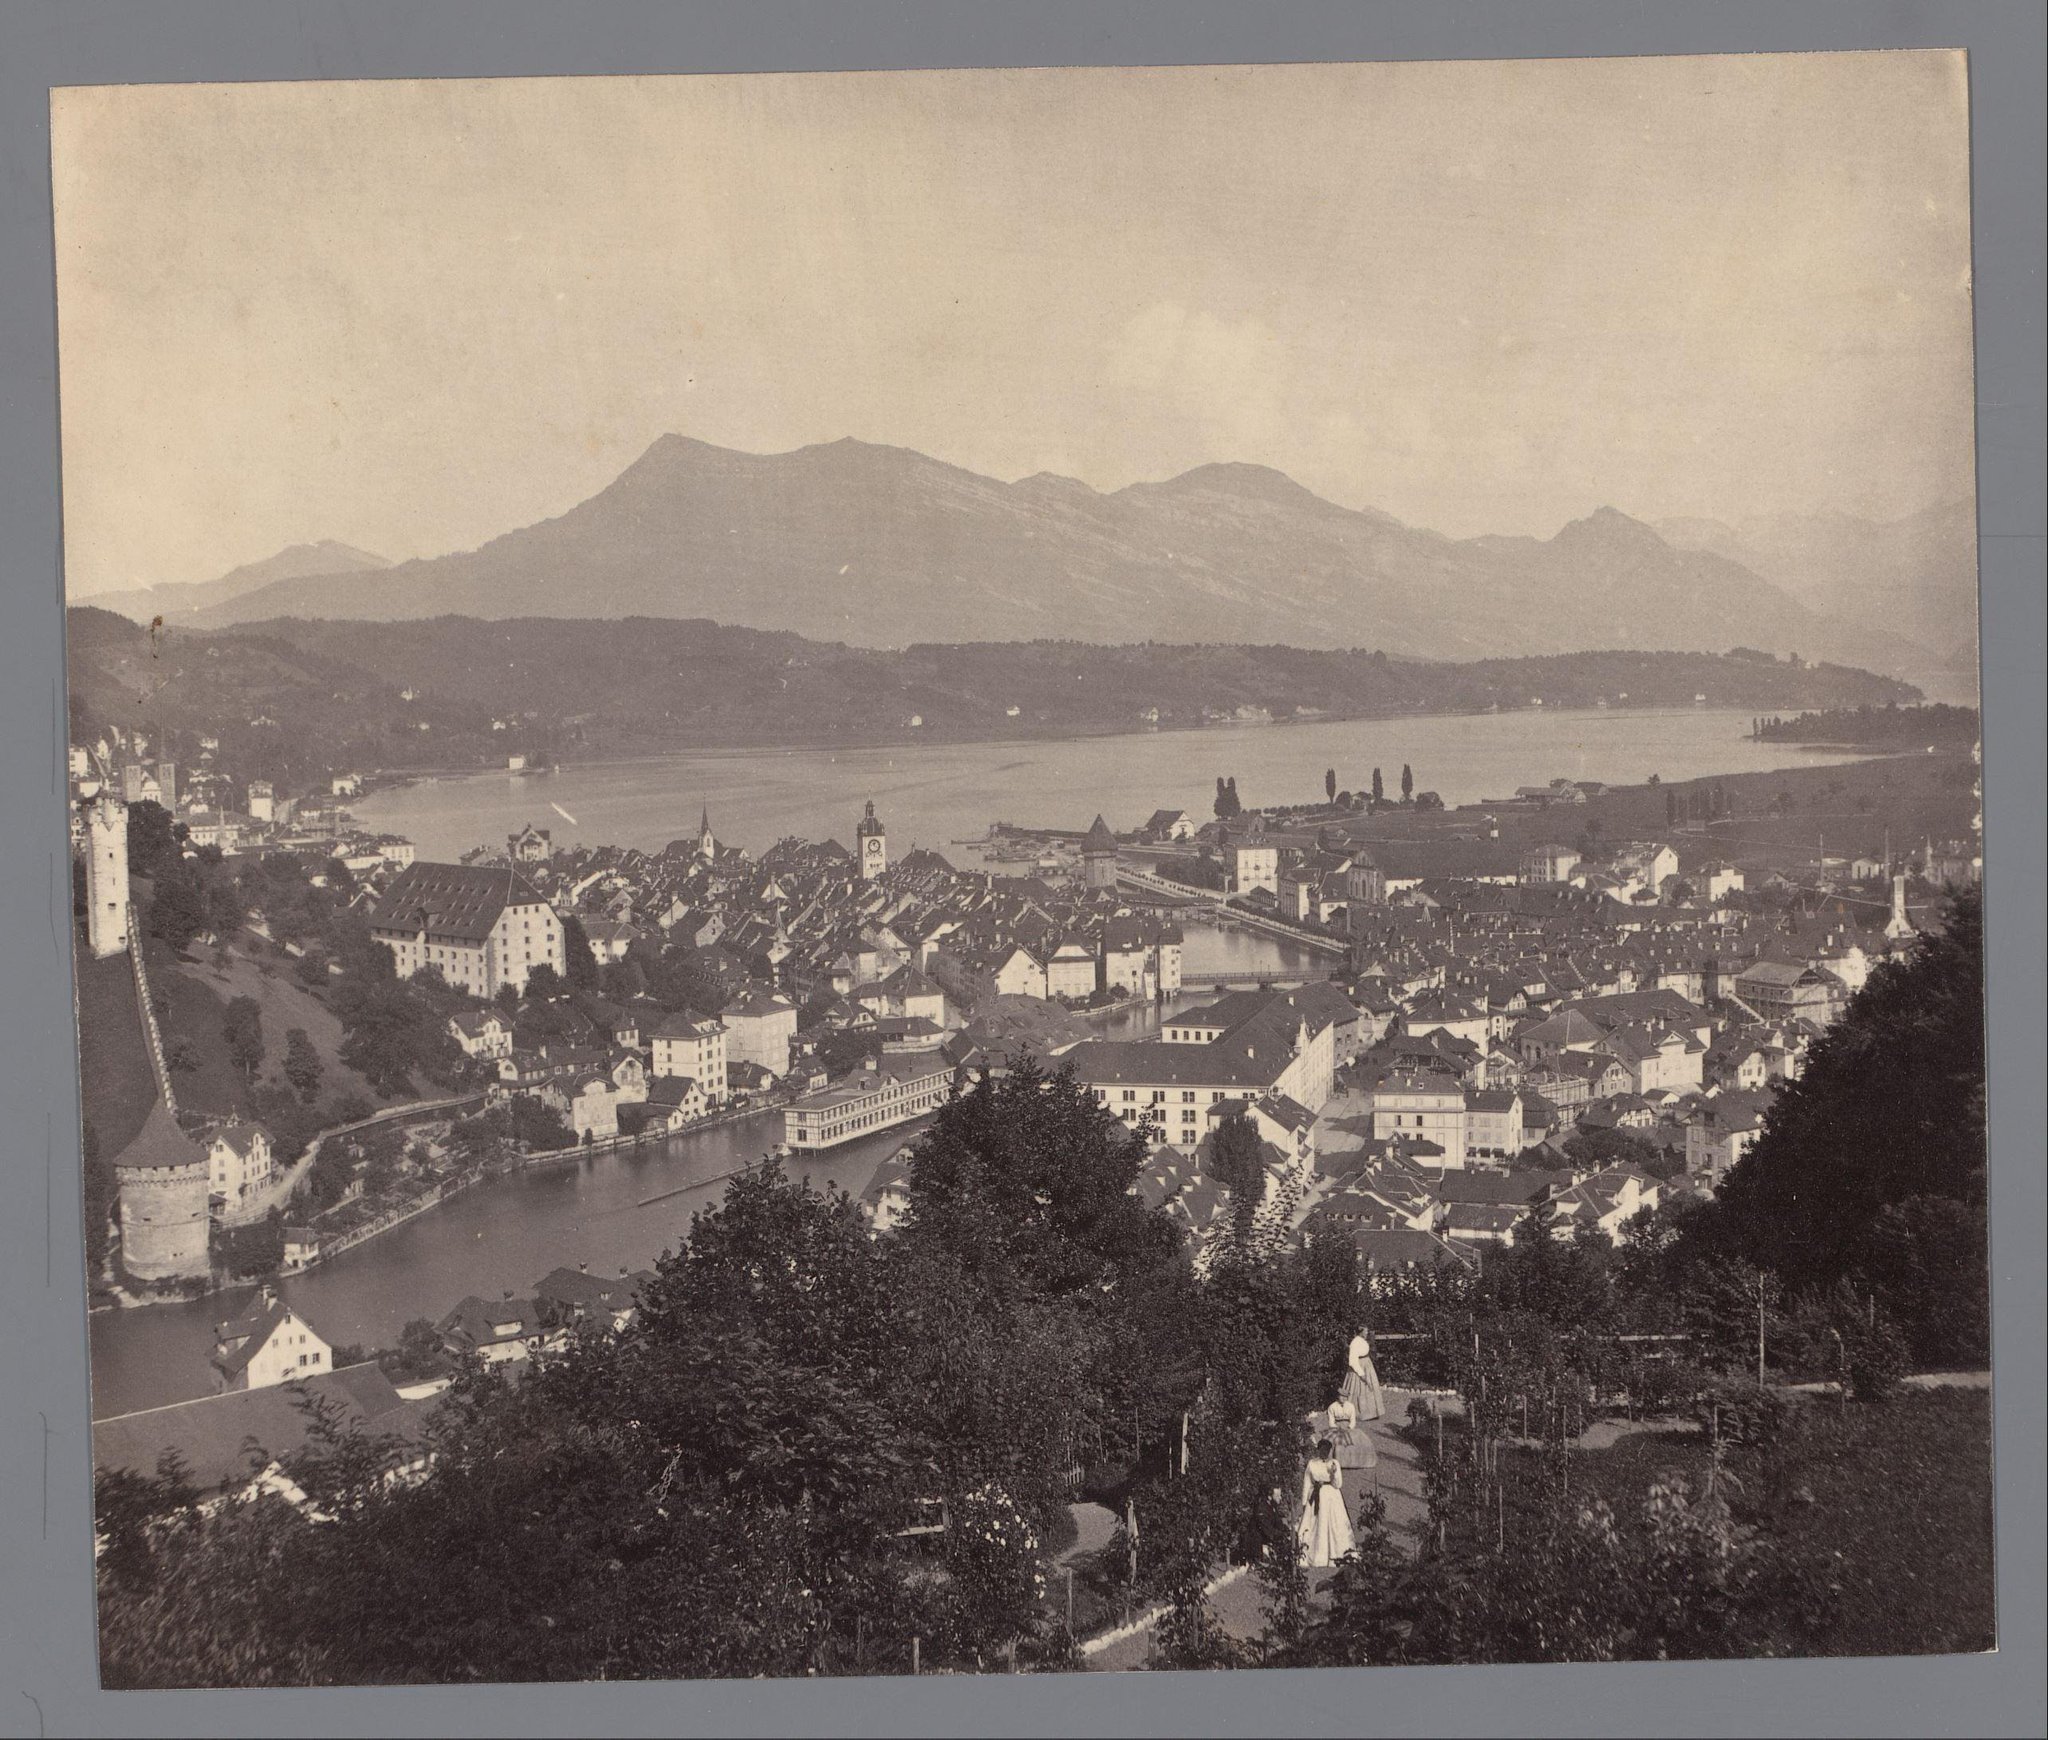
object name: photograph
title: Luzern en Mt. Rigi, Zwitserland, gezien vanuit Château Gütsch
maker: Anonymous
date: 1880-1900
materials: paper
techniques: albumen print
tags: luzern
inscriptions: inscription: ‘anonumous possbly Adolf [sic] Braun//f40,-’, number: ‘1090’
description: Bergketen [Alpen?] in Oostenrijk, Italië, Zwitserland of Duitsland.